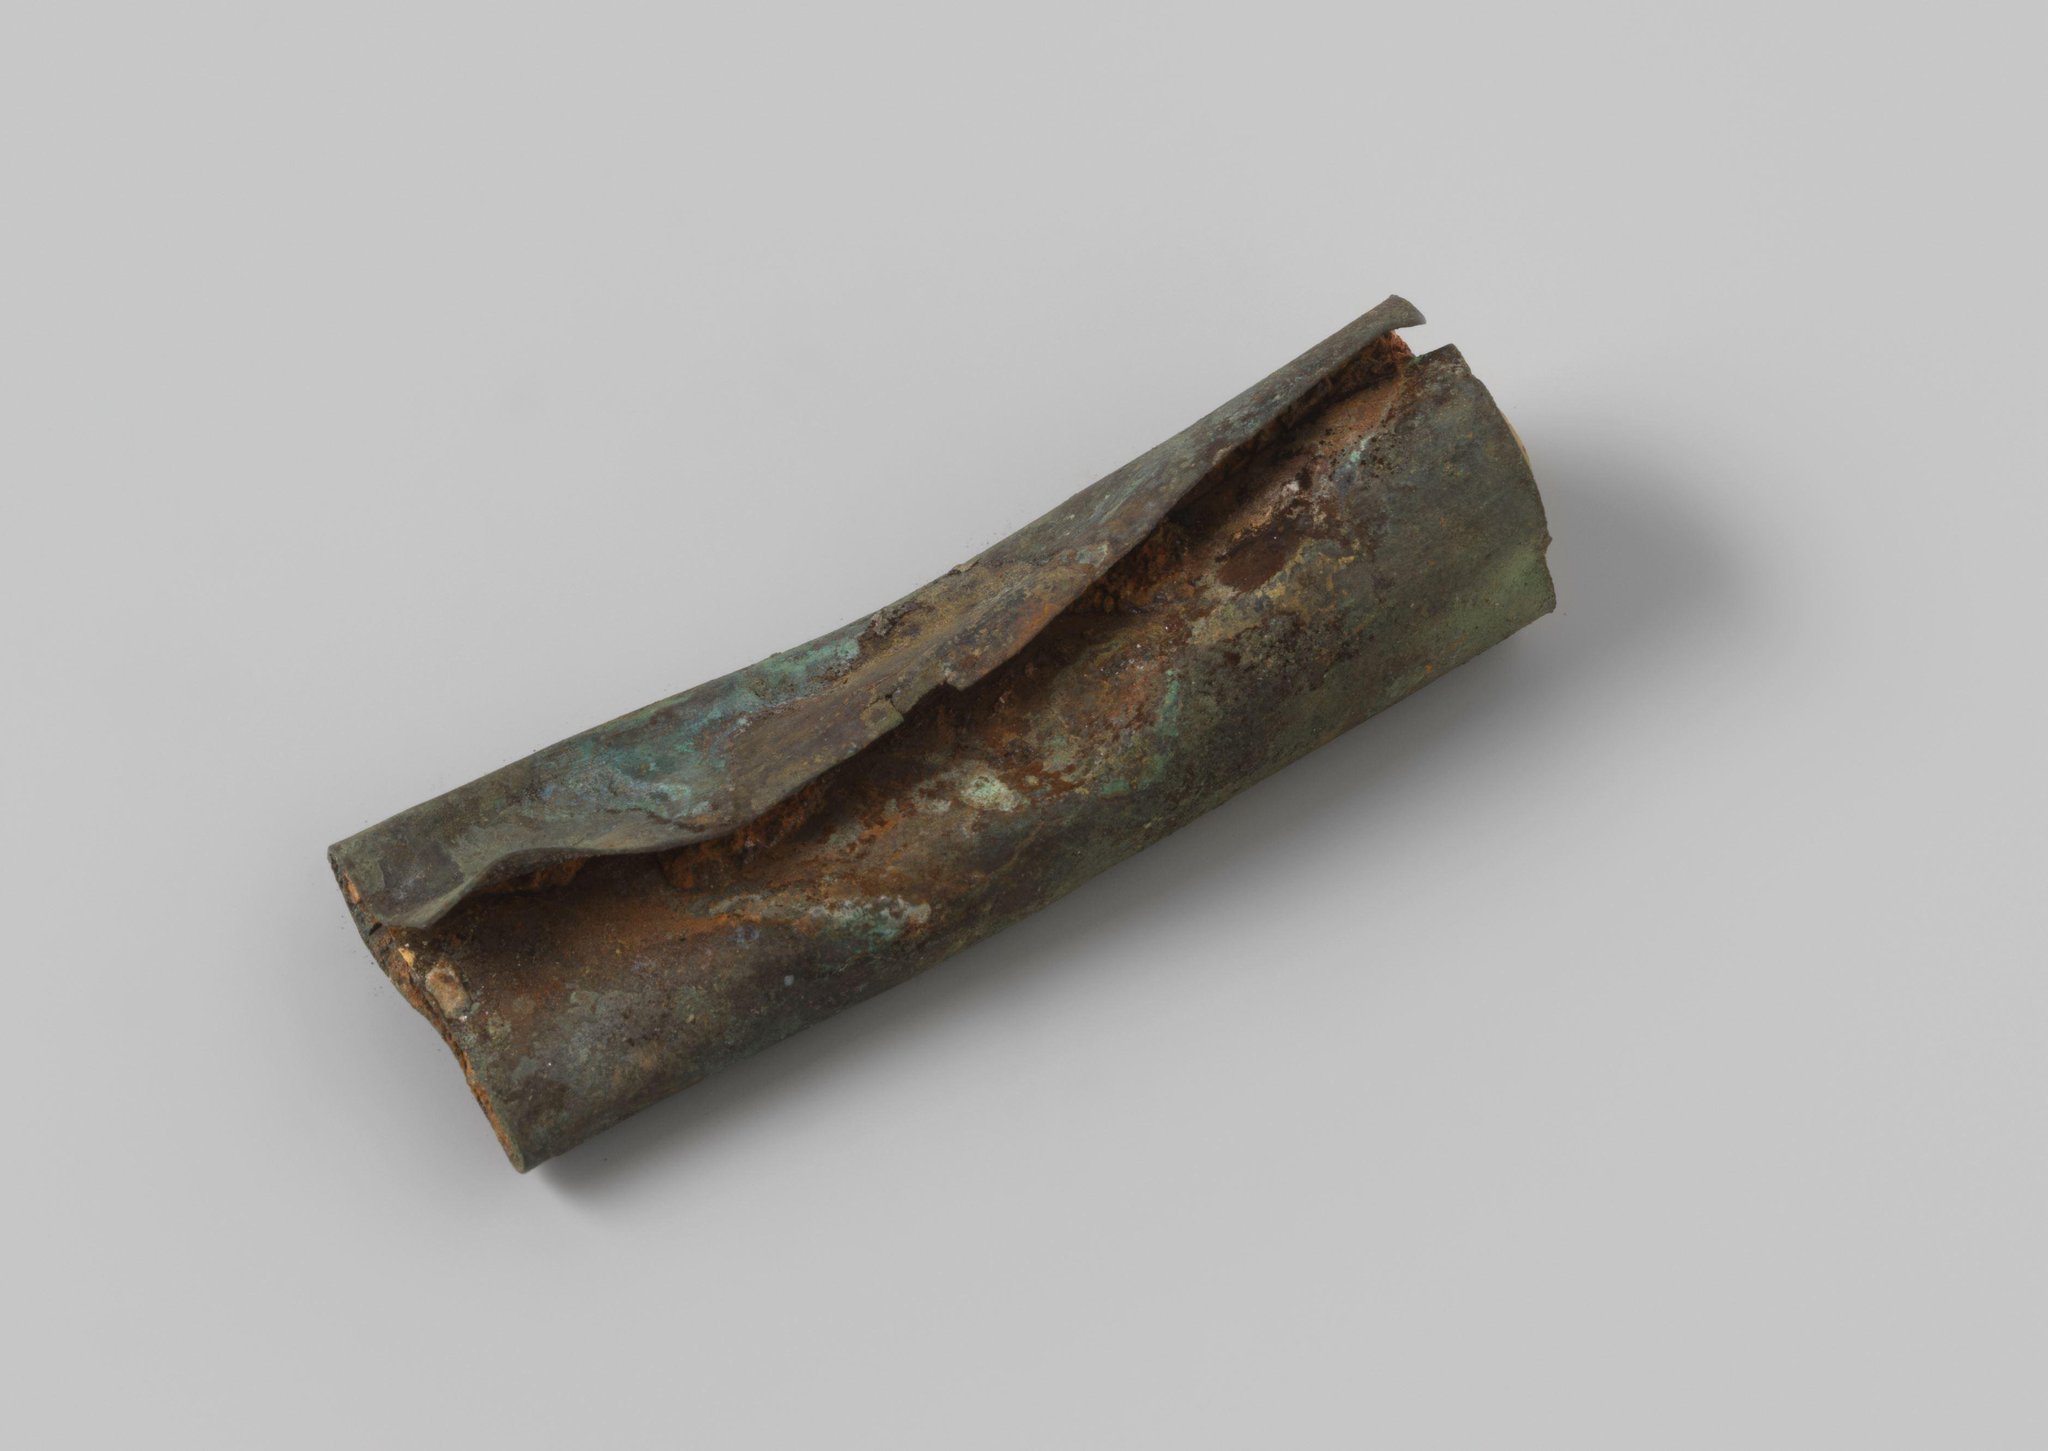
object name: cartridge shell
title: Patroonhuls met kogel uit het wrak van de Oost-Indiëvaarder Hollandia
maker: Anonymous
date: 1700-1743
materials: copper, lead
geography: netherlands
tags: verenigde oostindische compagnie, hollandia (schip), annet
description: Cartridge case, tube; squashed, id. NG 1979-205H549.